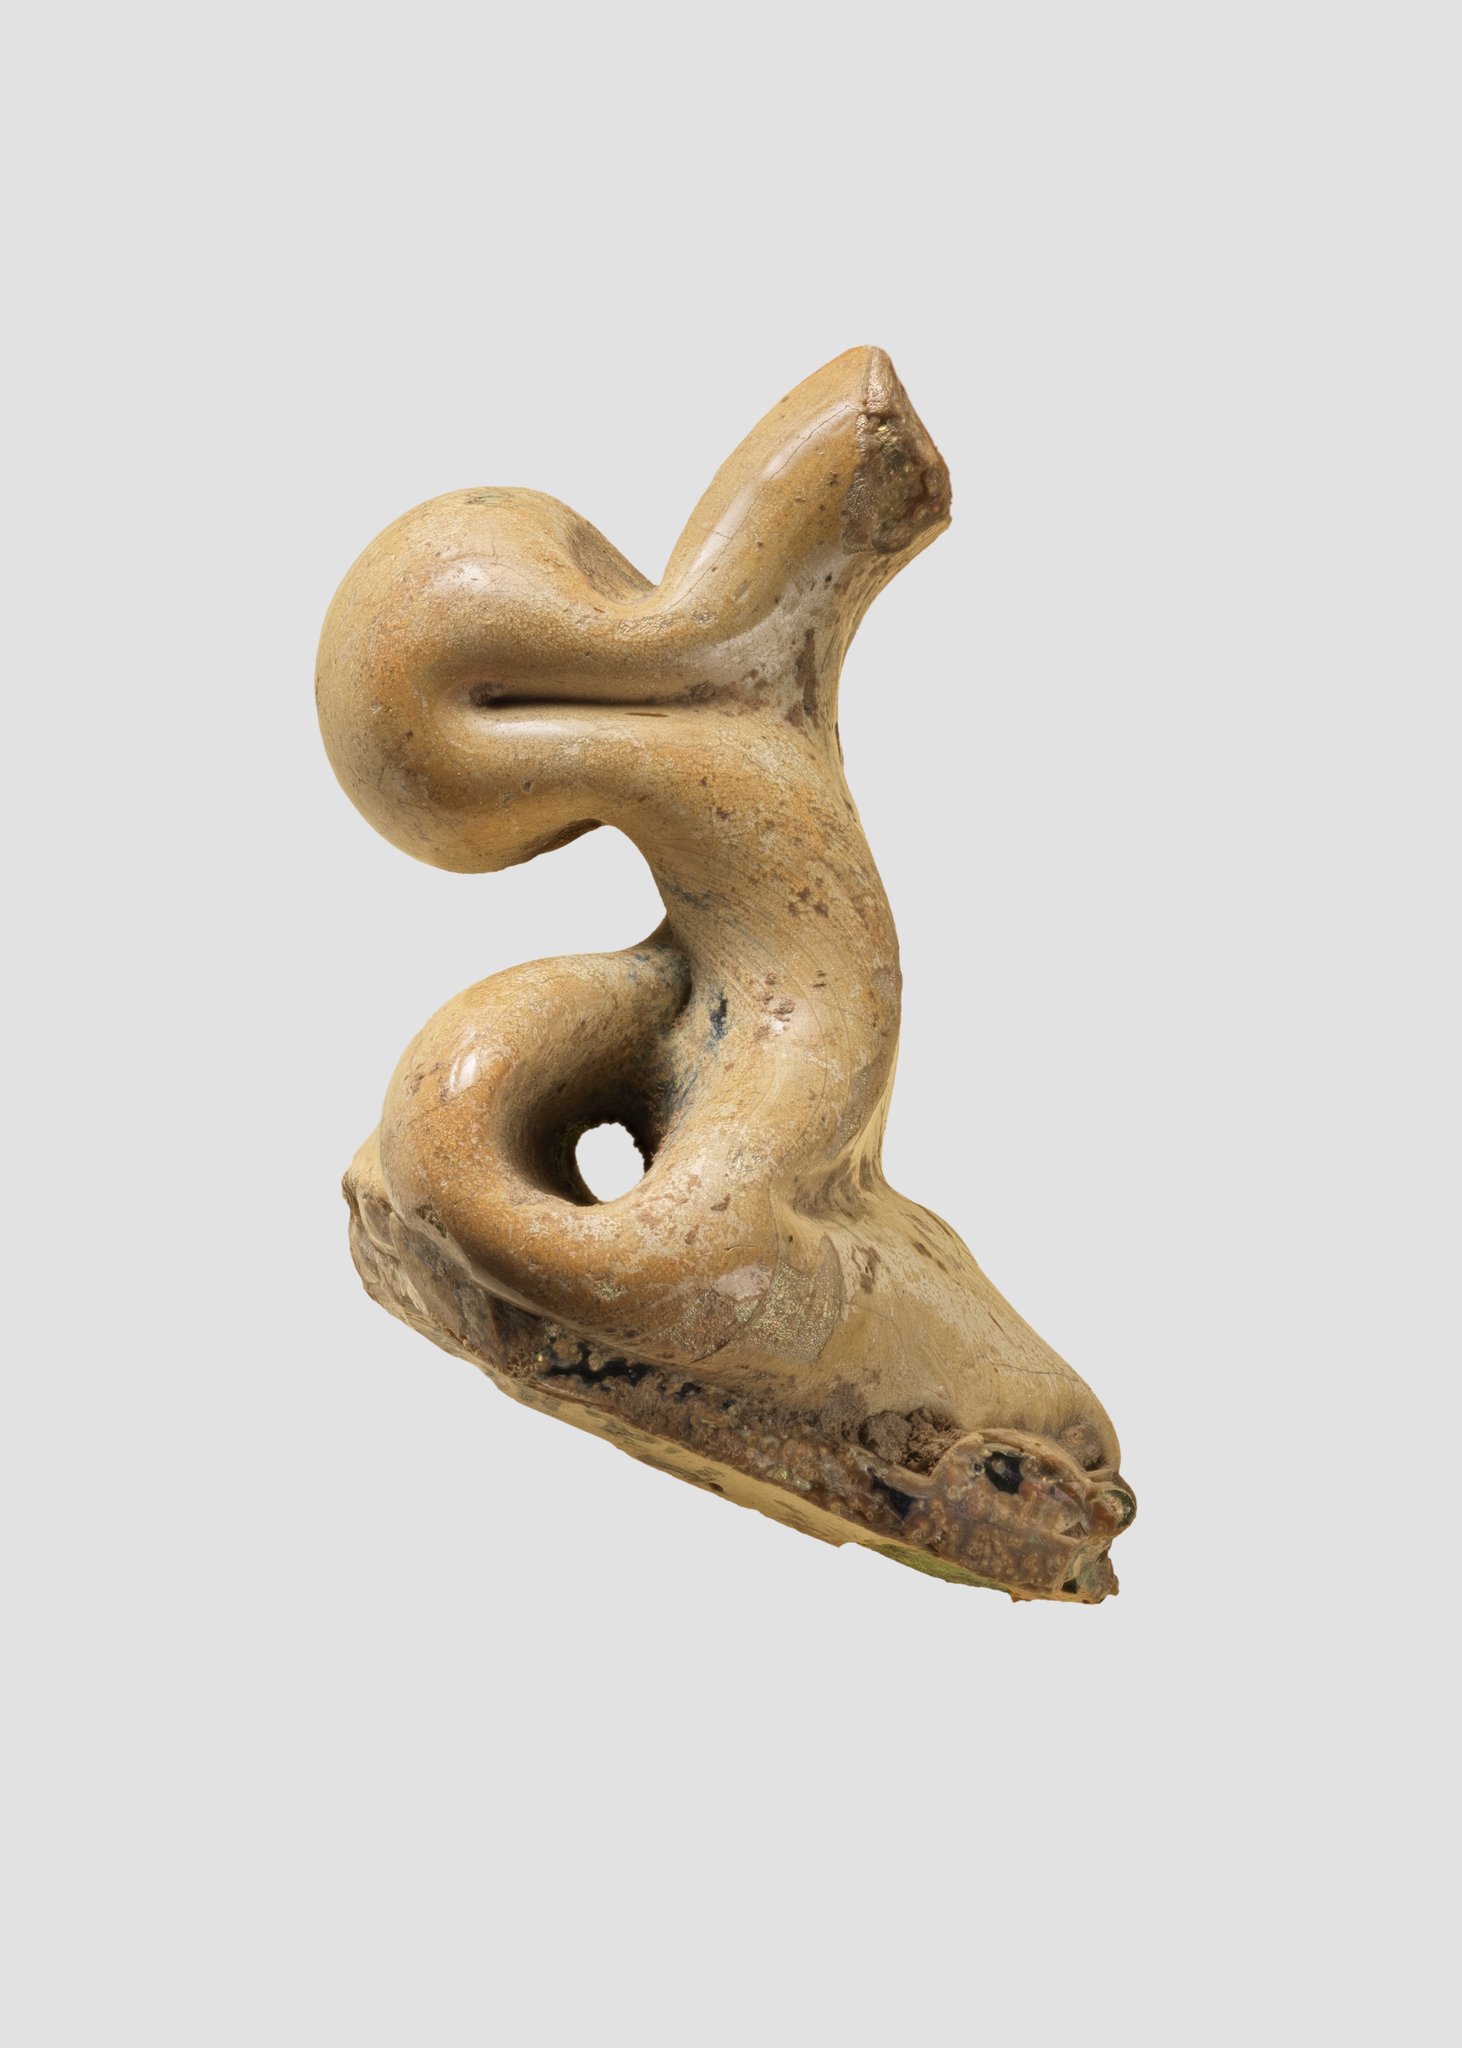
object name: handle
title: Handle fragment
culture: sasanian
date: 201-700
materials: glass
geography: mesopotamia